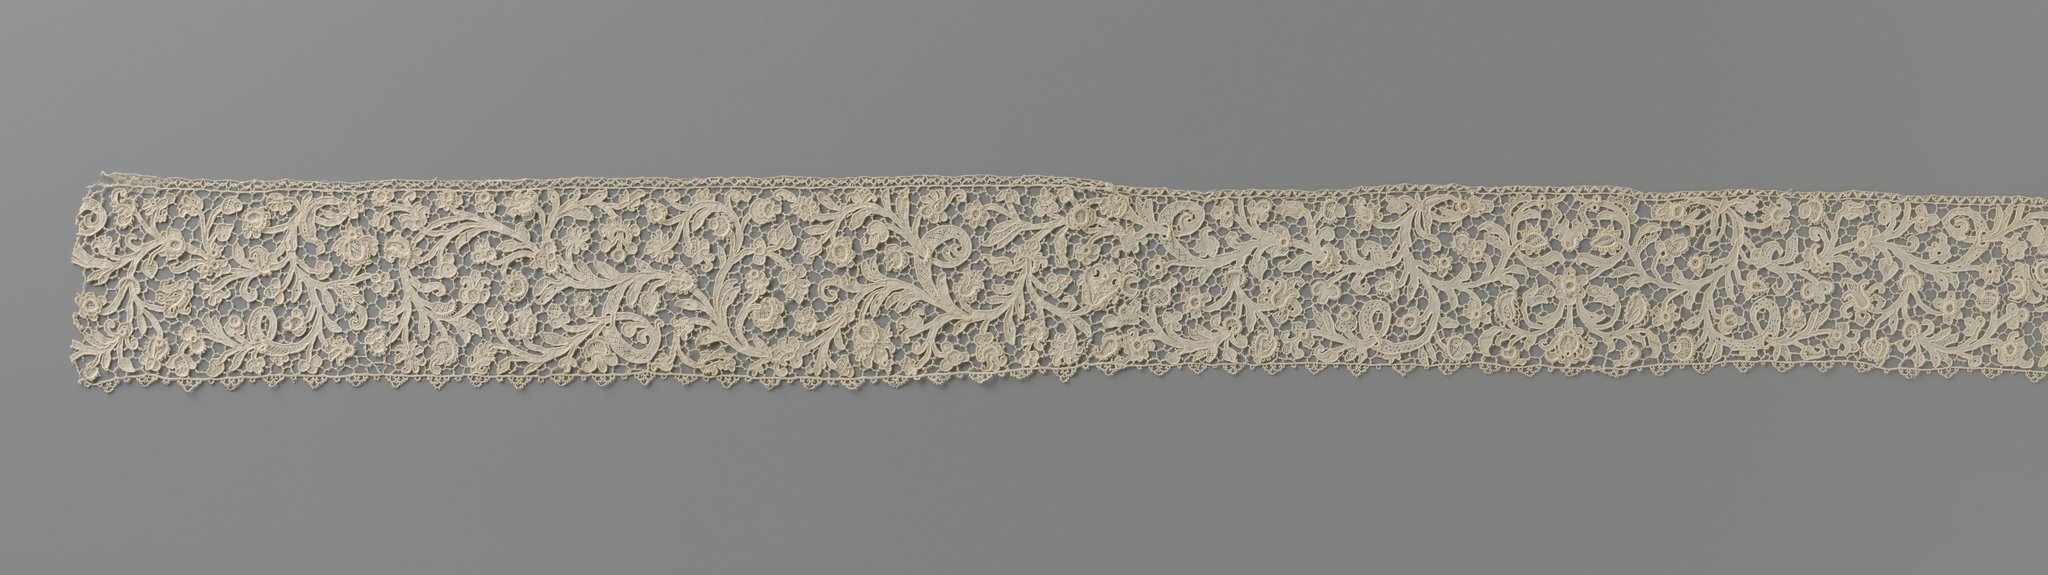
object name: strip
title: Strook naaldkant met gepluimde ranken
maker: Anonymous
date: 1875-1895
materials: linen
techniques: rose point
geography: burano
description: Strook naturelkleurige naaldkant: Venetiaanse rozenkant. Op een spijlengrond met zeszijdige mazen staan rijkvertakte, naar links en rechts zwenkende ranken, soms toegewend, soms lopend. Hieraan groeien veelsoortige, zorgvuldig gedetailleerde knopvormige bloempjes. Hier en daar is de top van een rank door een opening in de tak heen gegroeid. Rechte afwerking van beurtelings een oogje en een driehoek.